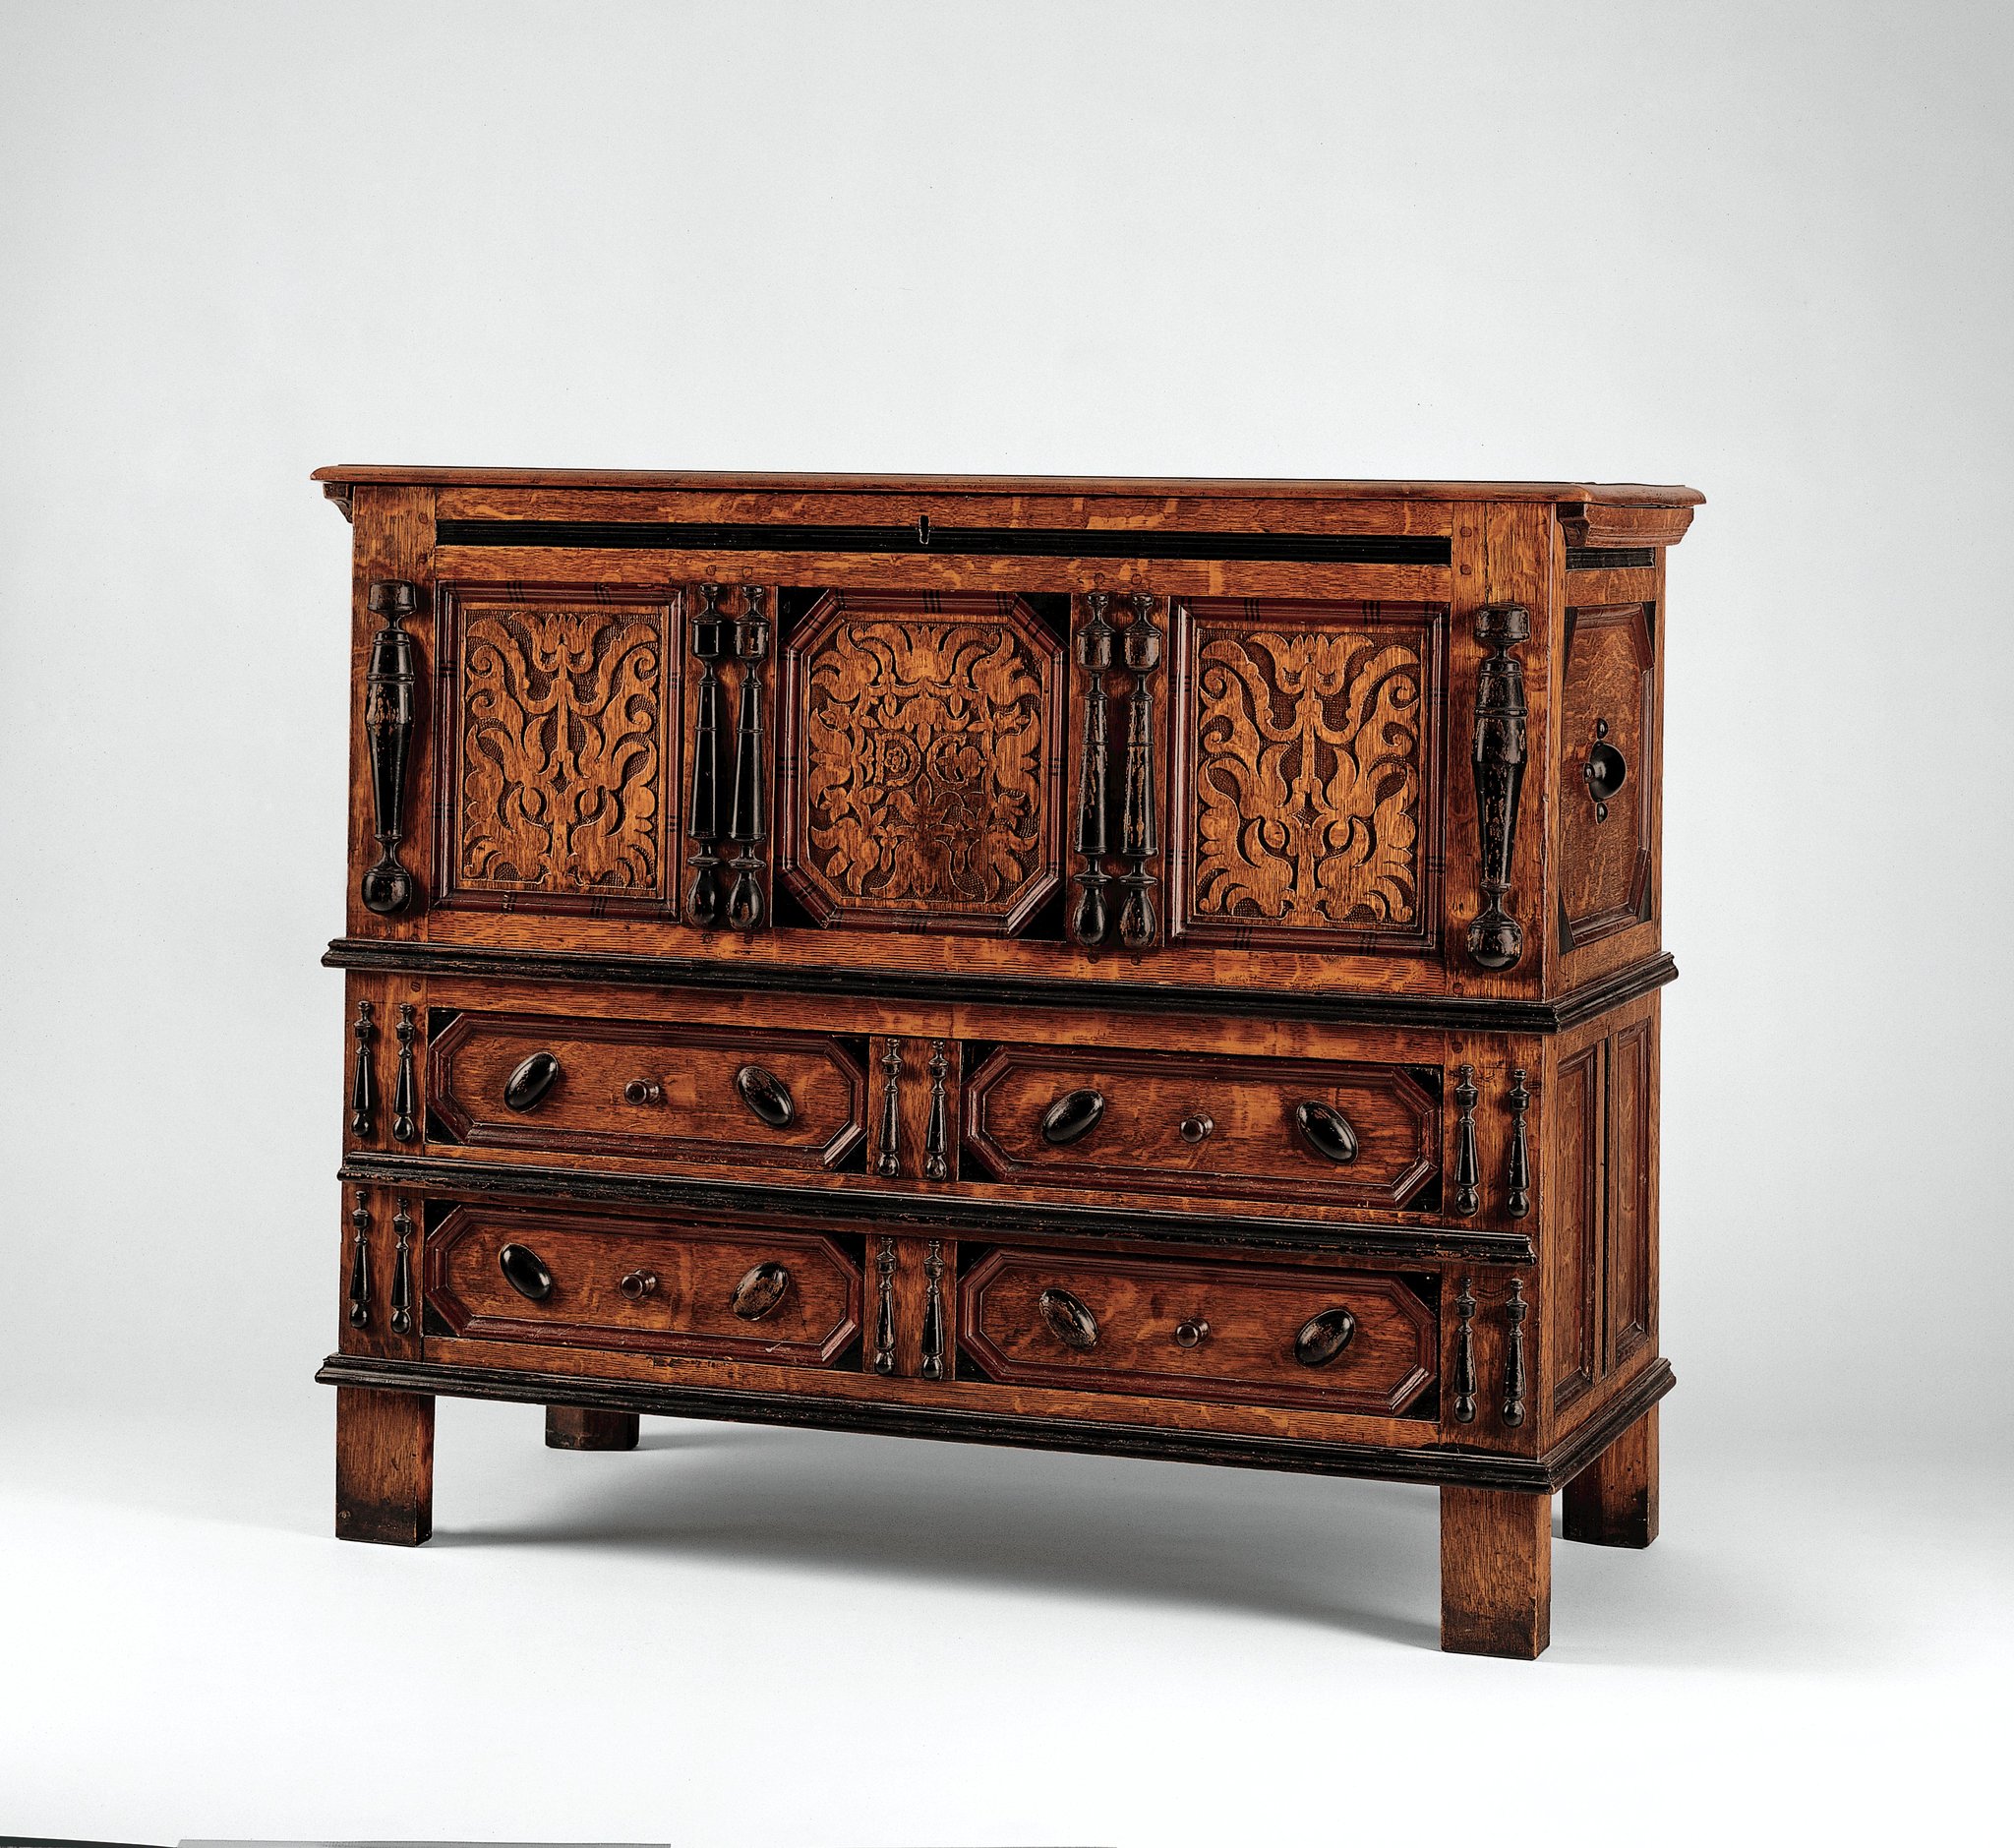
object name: chest of drawer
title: Chest with drawers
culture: american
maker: peter blin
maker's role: maker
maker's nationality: american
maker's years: 1672-1725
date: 1675-1700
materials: wood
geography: united states